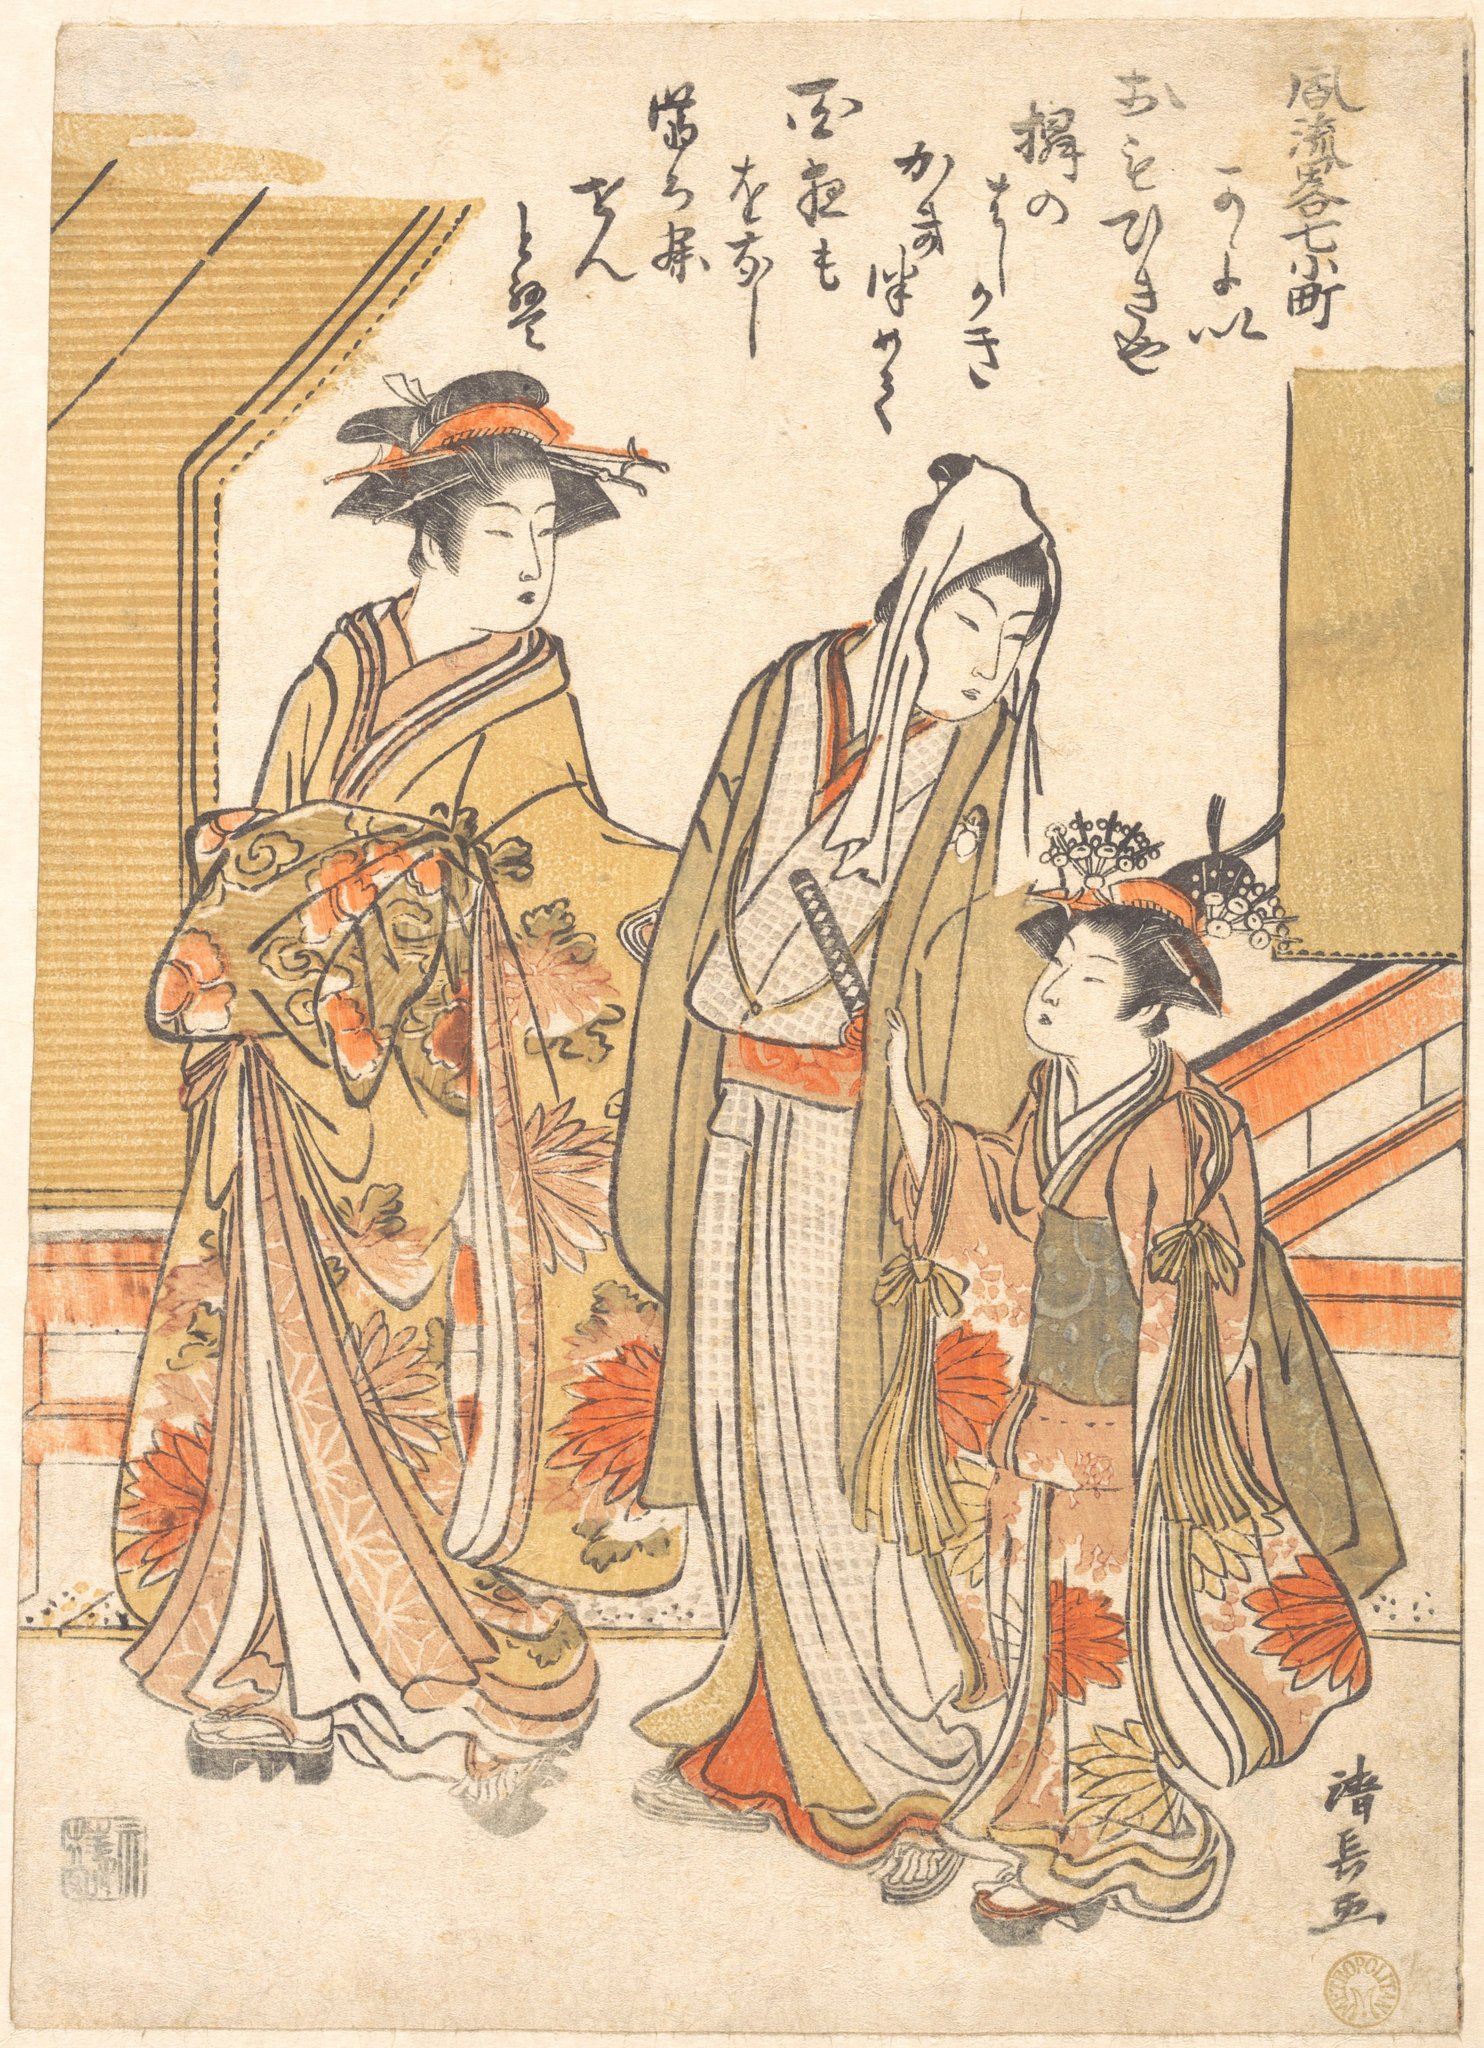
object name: print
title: Visiting Komachi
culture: japanese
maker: torii kiyonaga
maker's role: artist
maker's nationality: japanese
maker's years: 1752-1815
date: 1779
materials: ink, paper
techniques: woodblock print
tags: girls,women